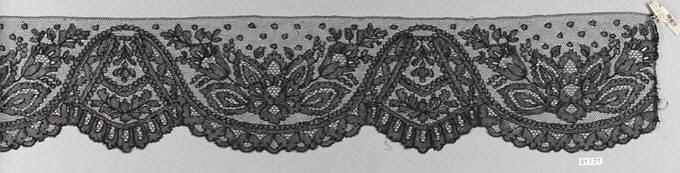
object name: border or flounce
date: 1801-1900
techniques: lace